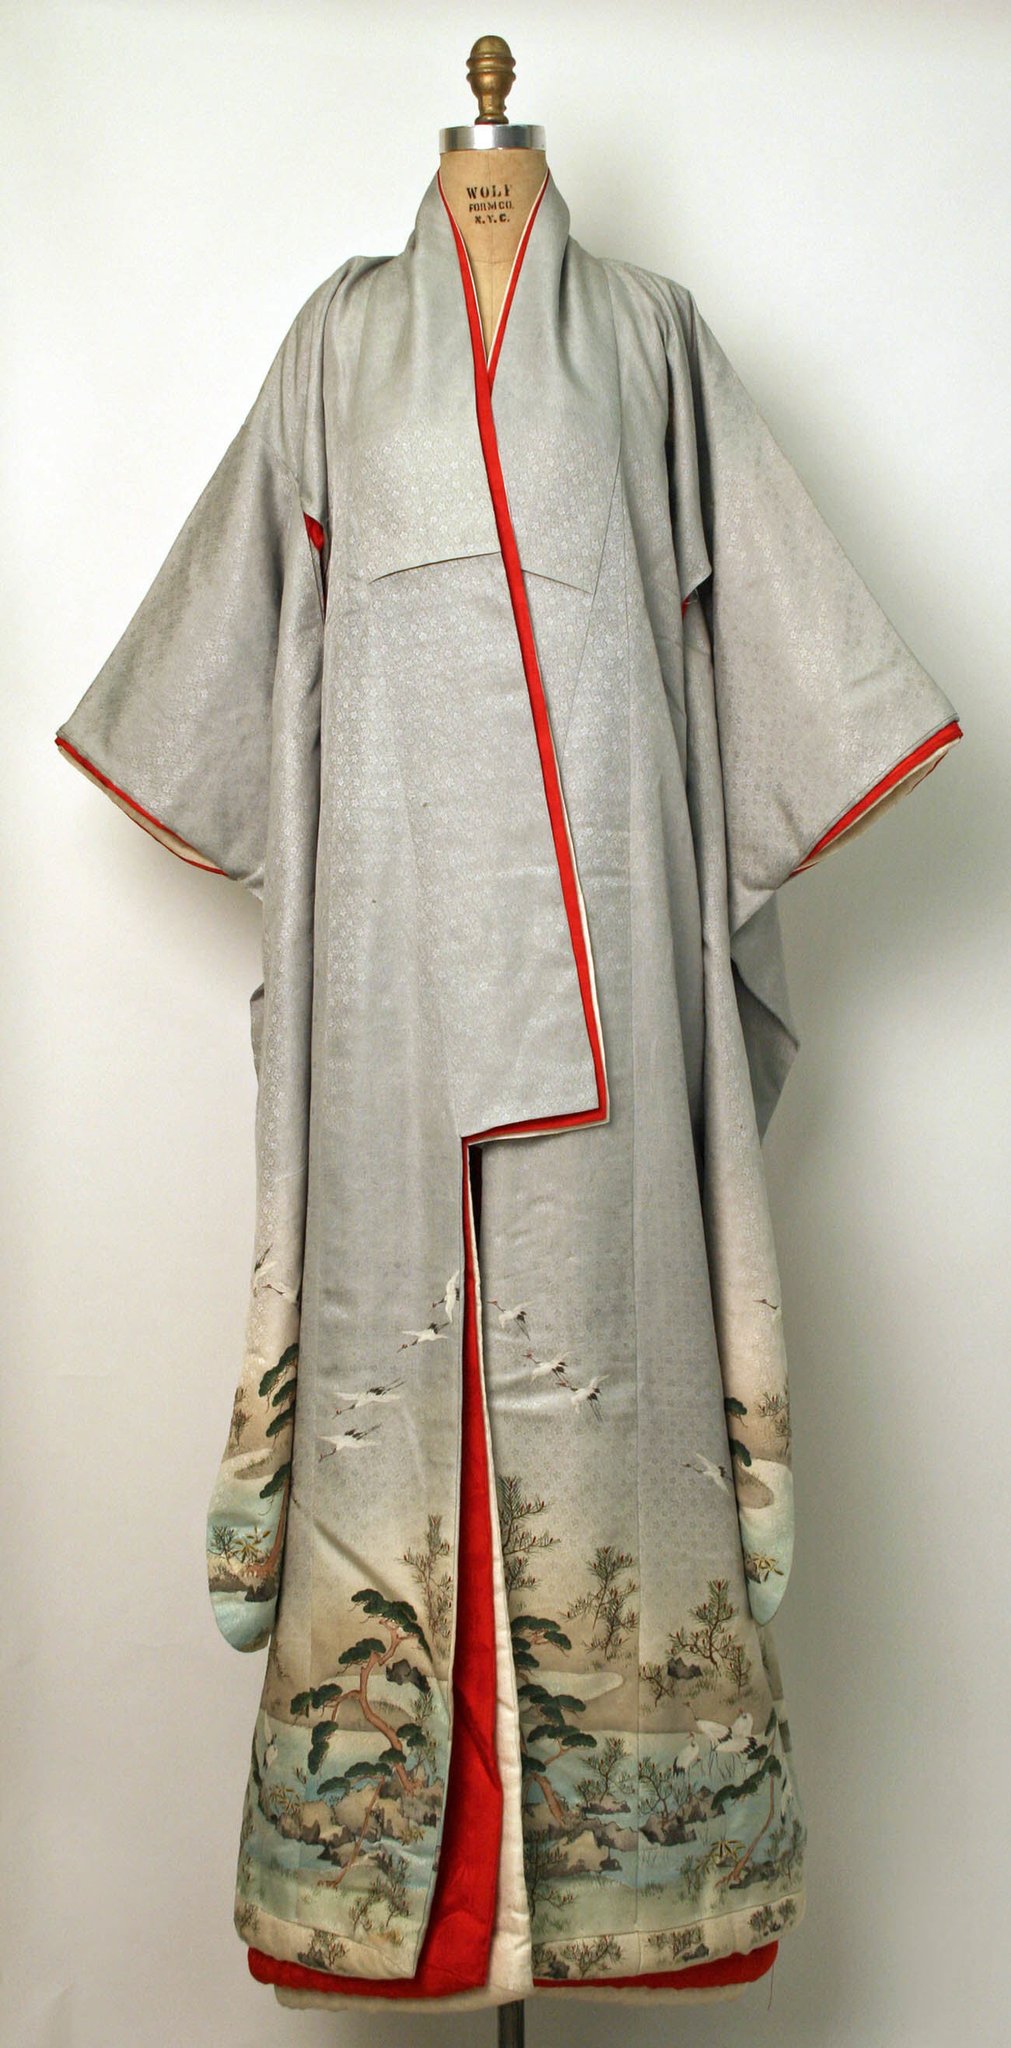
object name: kimono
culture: japanese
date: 1800-1941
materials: silk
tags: cranes,landscapes